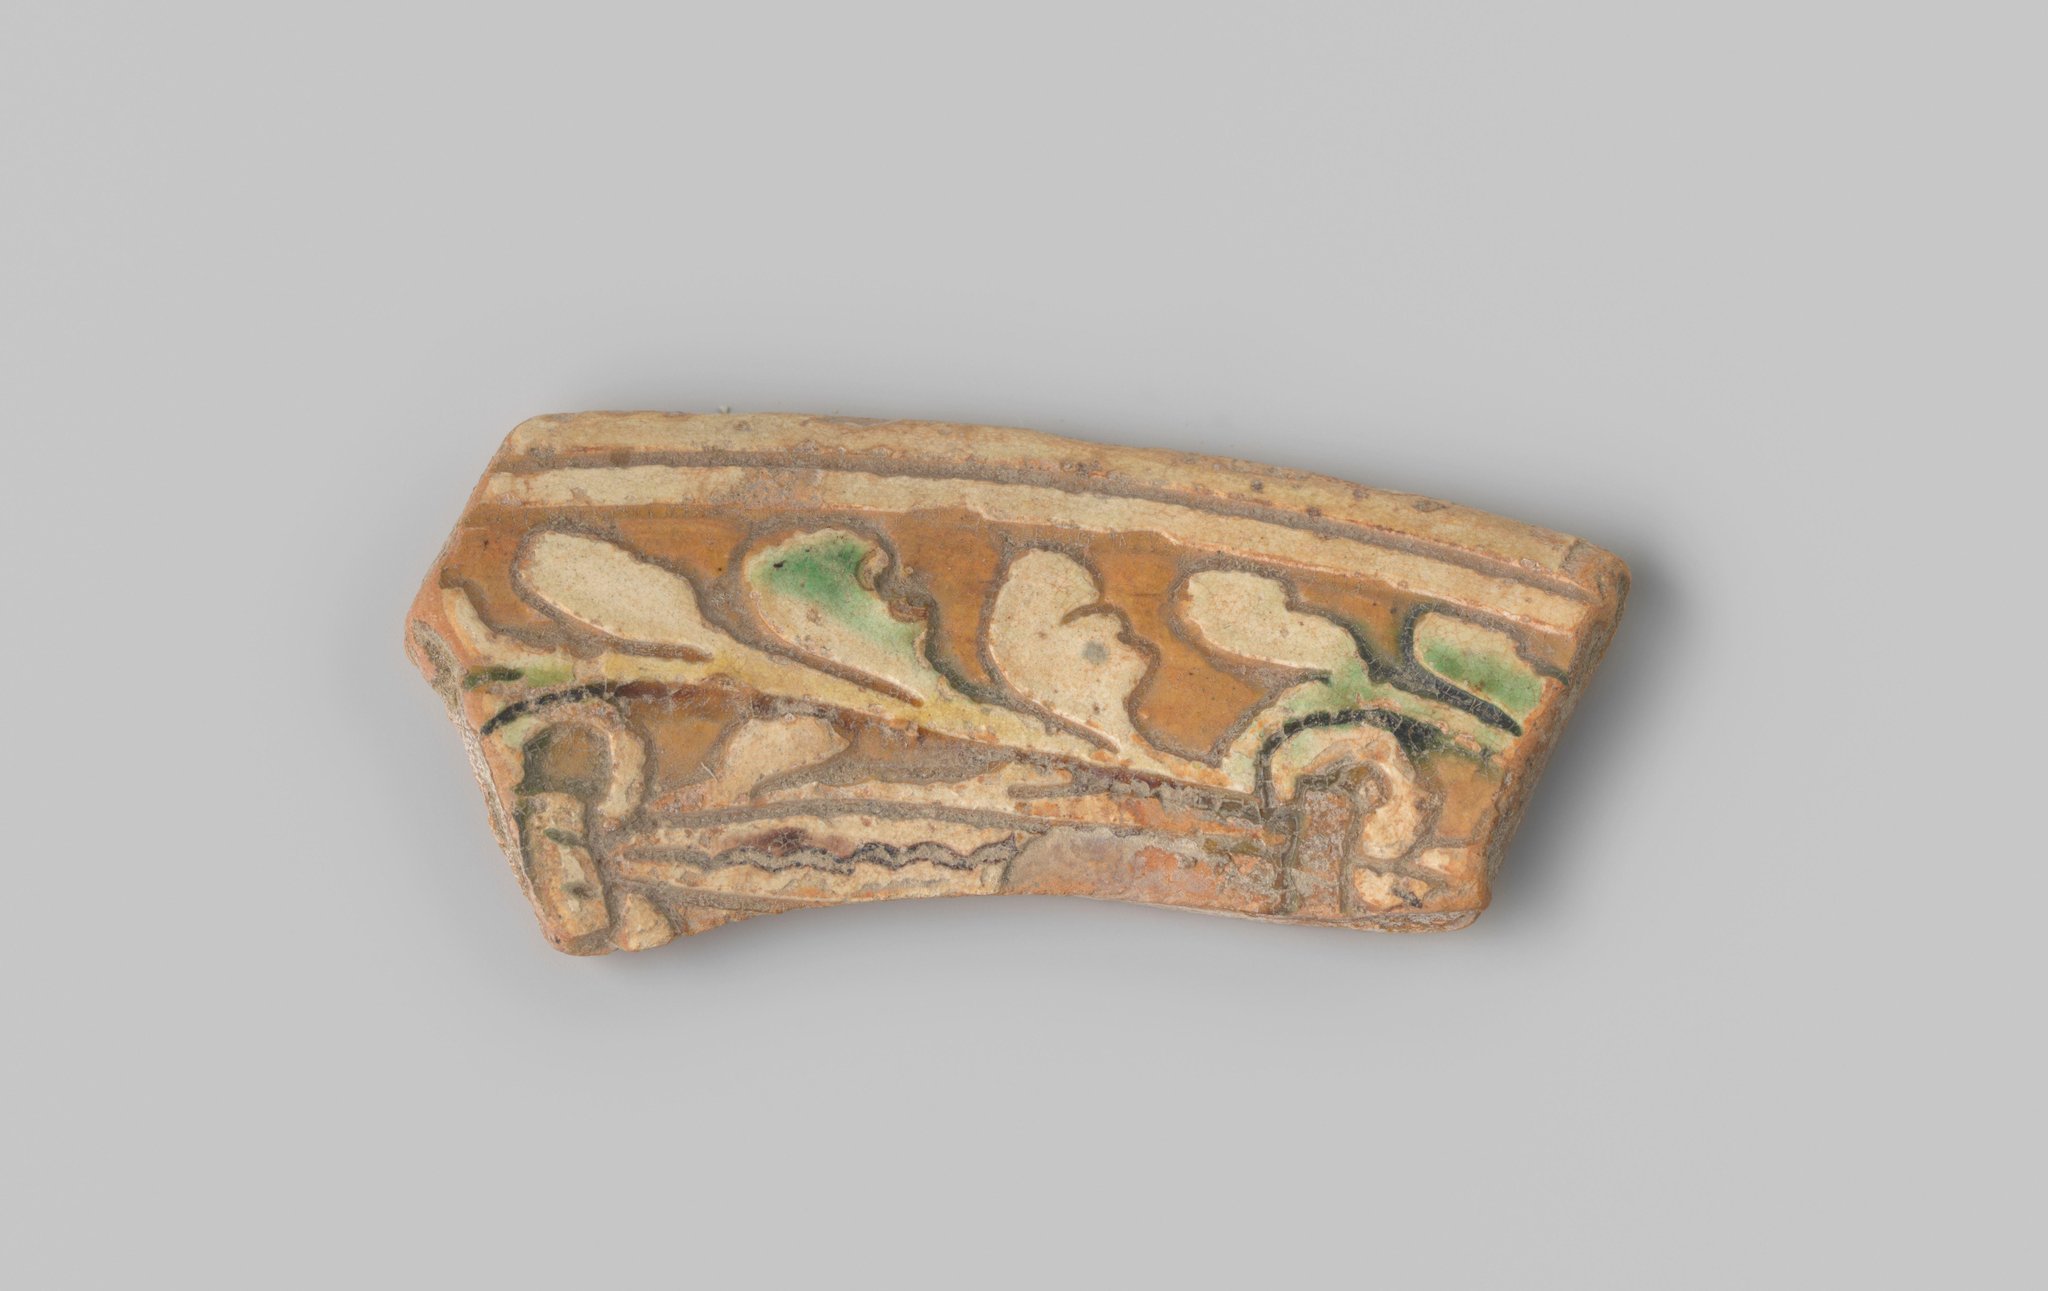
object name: sherd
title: Fragment van aardewerk met rossige scherf, aan de voorzijde voorzien van een bladrank in sgrafitto-techniek, deels voorzien van wit glazuur, aan de achterzijde voorzien van wit glazuur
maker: Anonymous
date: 1200-1899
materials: earthenware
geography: italy